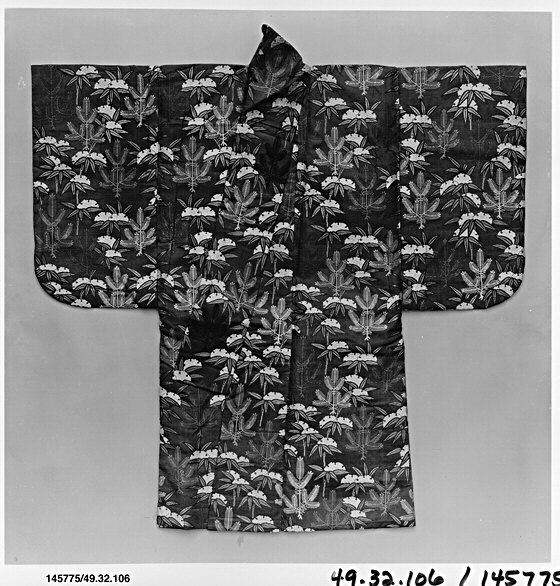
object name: noh robe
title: Noh Robe (Karaori) with Pattern of Young Pines and Snow-Covered Bamboo on a Red Ground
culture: japanese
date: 1801-1900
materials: silk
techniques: patterning, weave